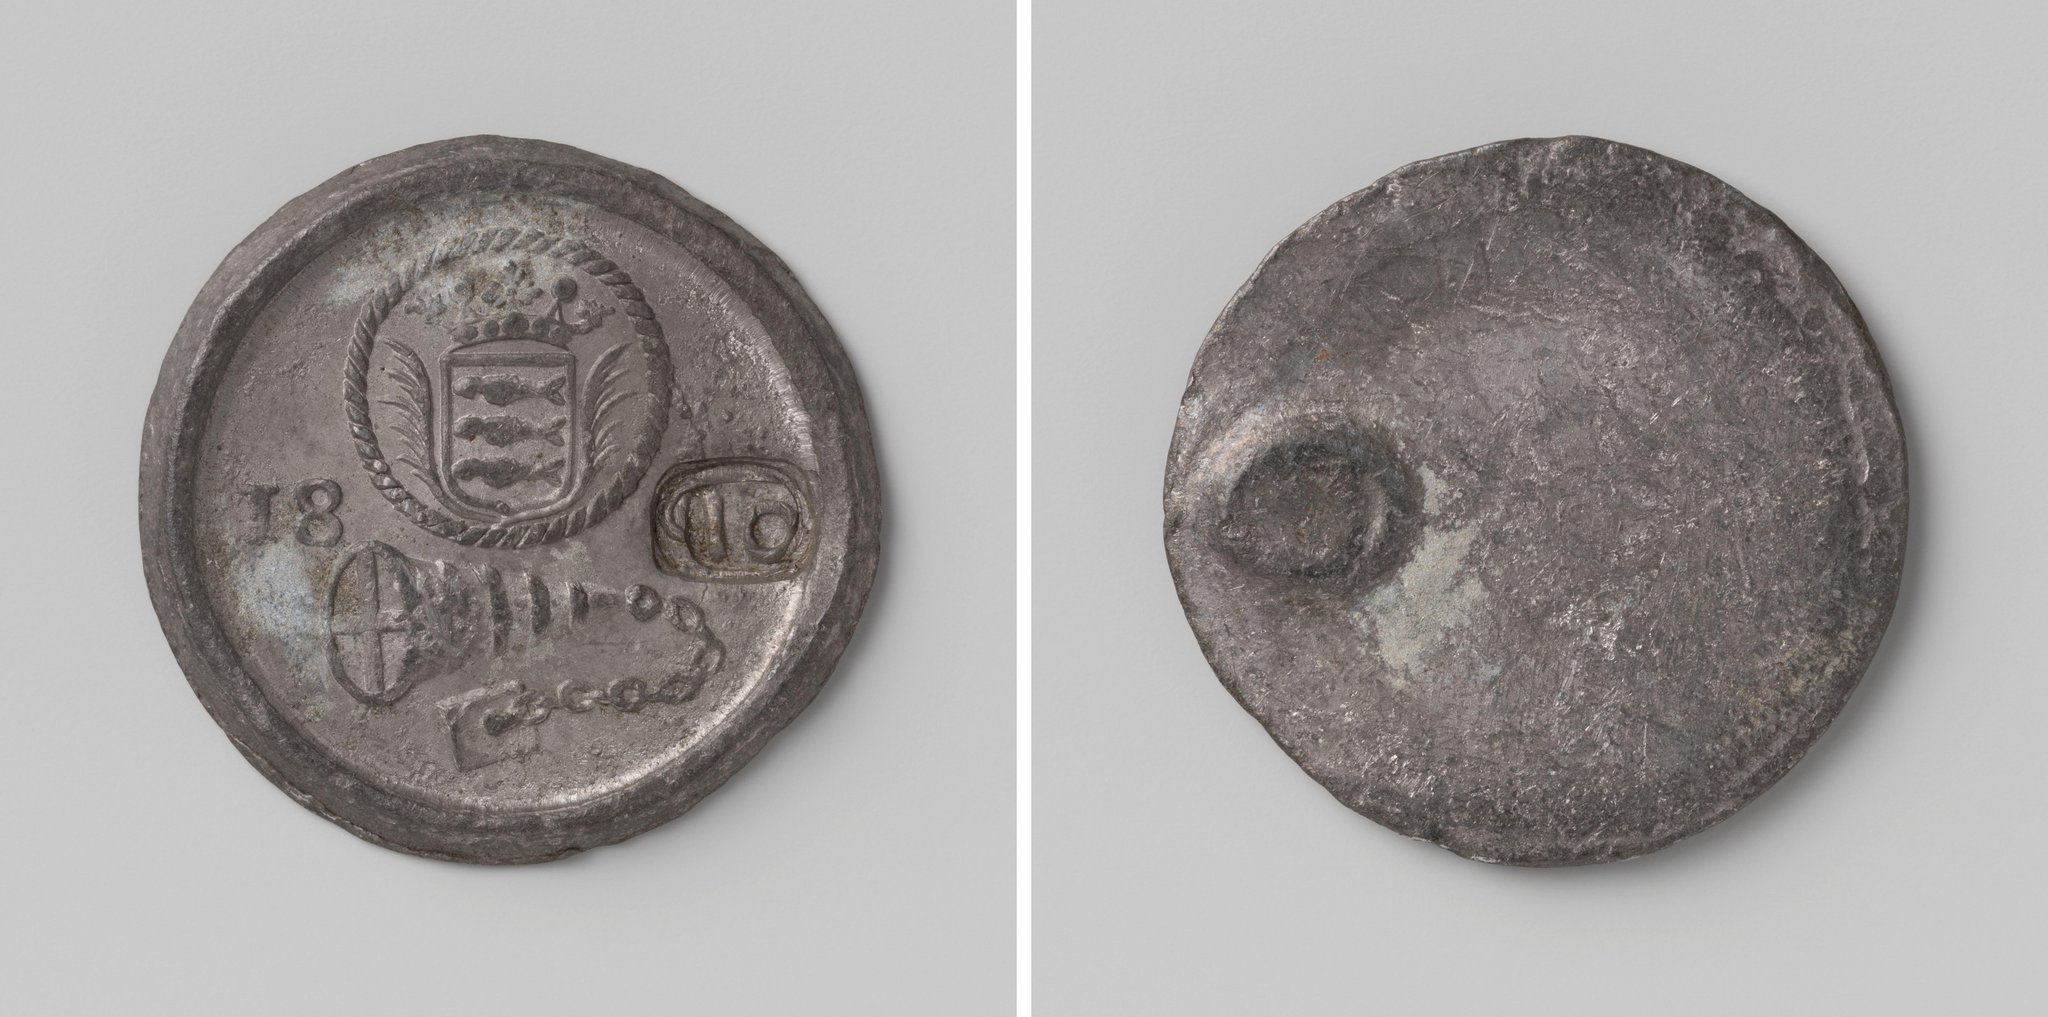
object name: tonnegeld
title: Stad Enkhuizen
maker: Anonymous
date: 1810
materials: lead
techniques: striking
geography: enkhuizen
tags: enkhuizen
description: eenzijdig loodje. Voorzijde: gekroond wapenschild op twee gekruiste takken binnen ronde kabelrand; daaronder: stempel tussen jaartal. Keerzijde: blanco